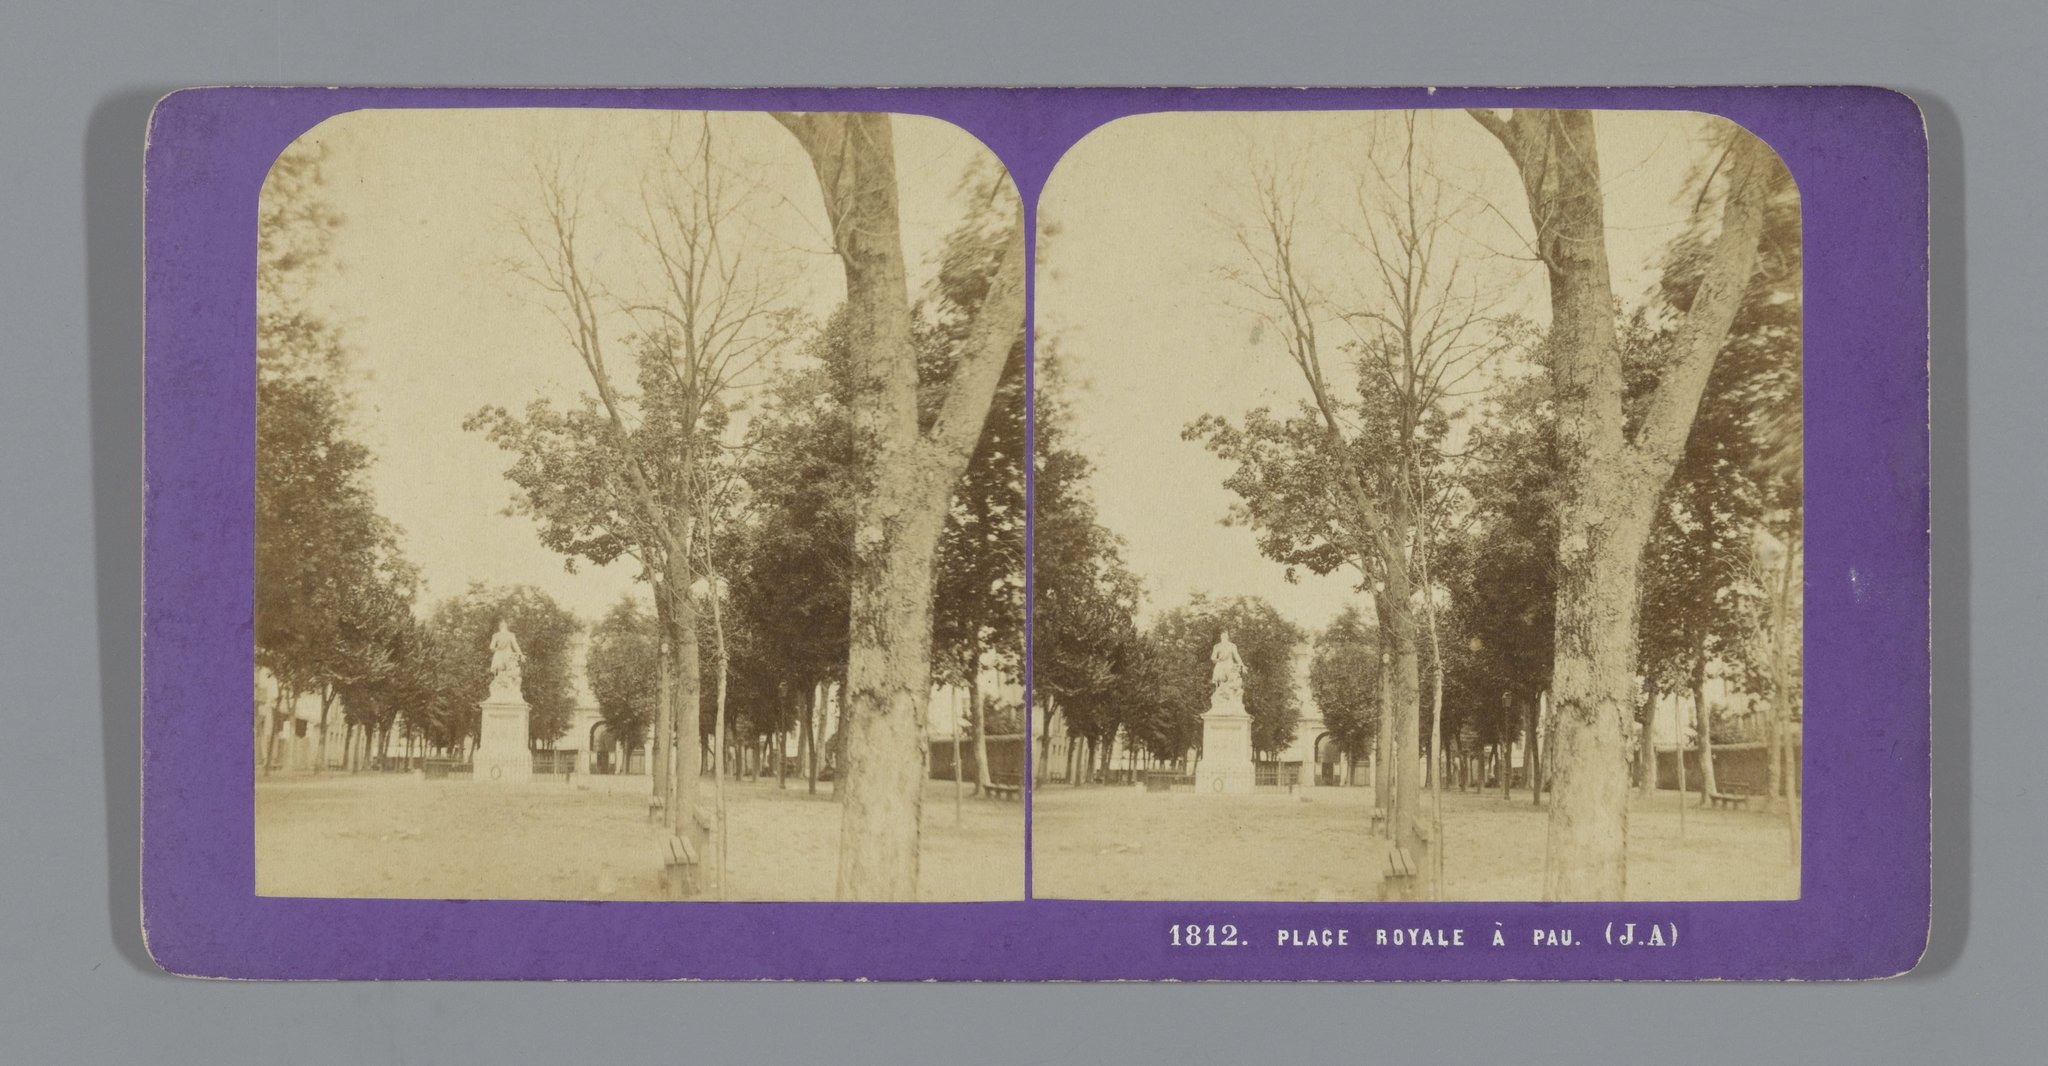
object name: stereograph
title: Place Royale te Pau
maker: jean andrieu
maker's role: fotograaf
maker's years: 1816-1872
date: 1862-1876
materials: cardboard, photographic support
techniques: albumen print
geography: pau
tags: public gardens, park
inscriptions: number: ‘1812.’